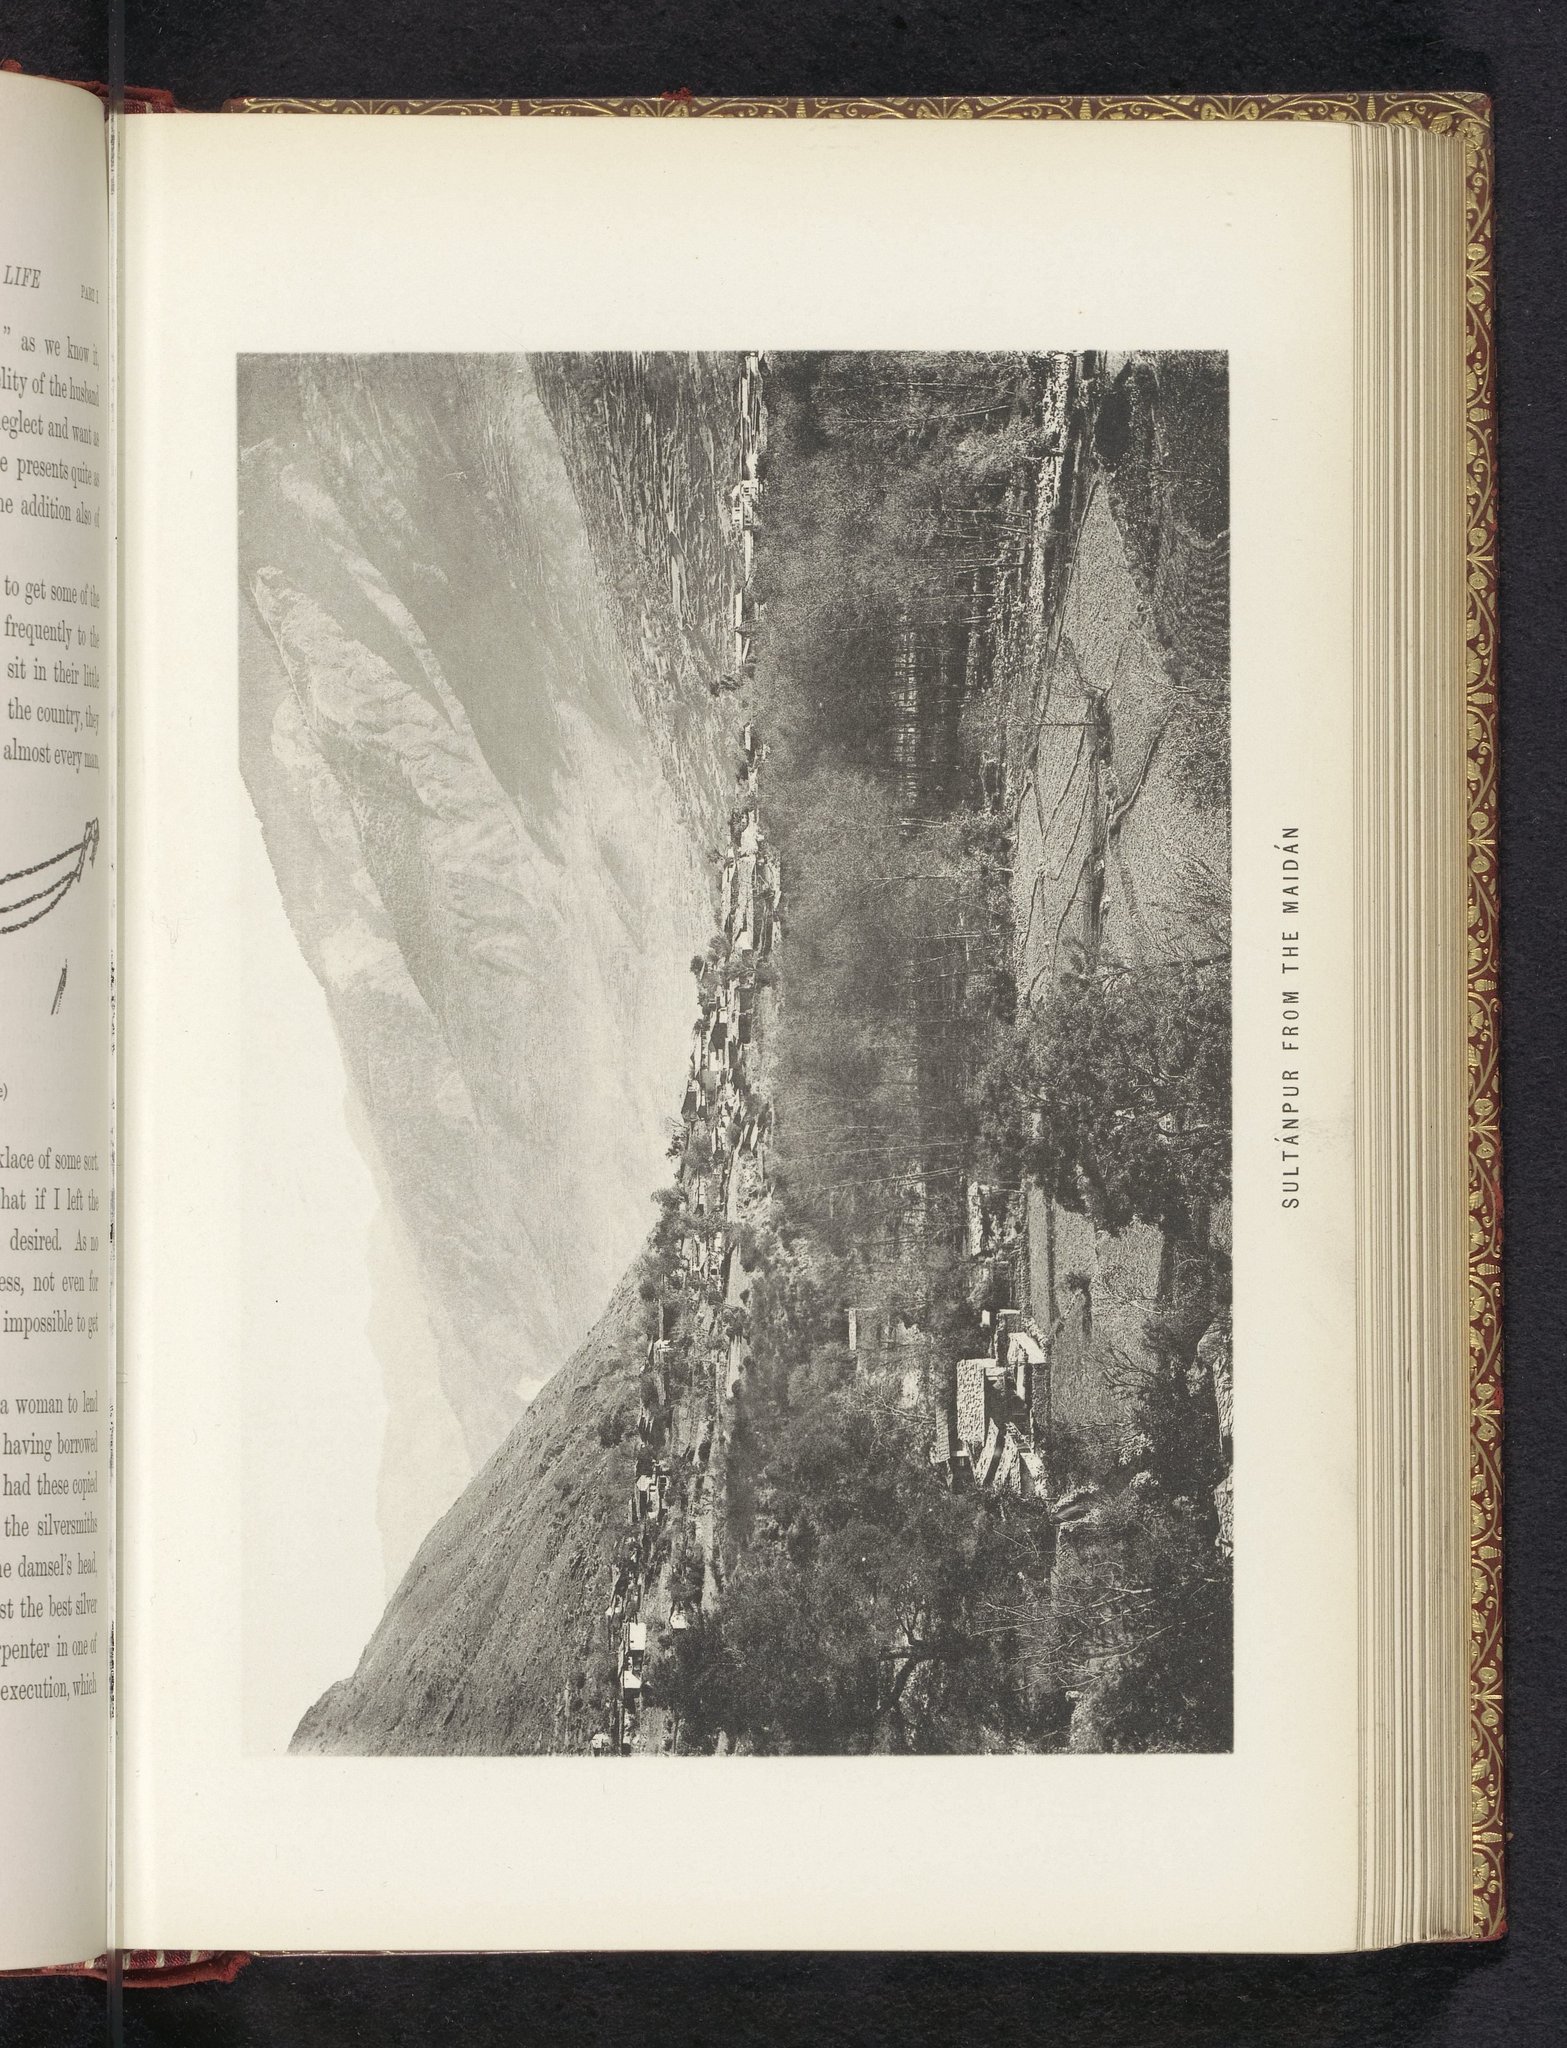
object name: photomechanical print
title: View of the Sultanpur area of Kullu, Himachal Pradesh, India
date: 1890-1895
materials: paper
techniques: photograph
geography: kullu valley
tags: dale, valley, city-view in general; 'veduta'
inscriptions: caption: ‘SULTÁNPUR FROM THE MAIDÁN’